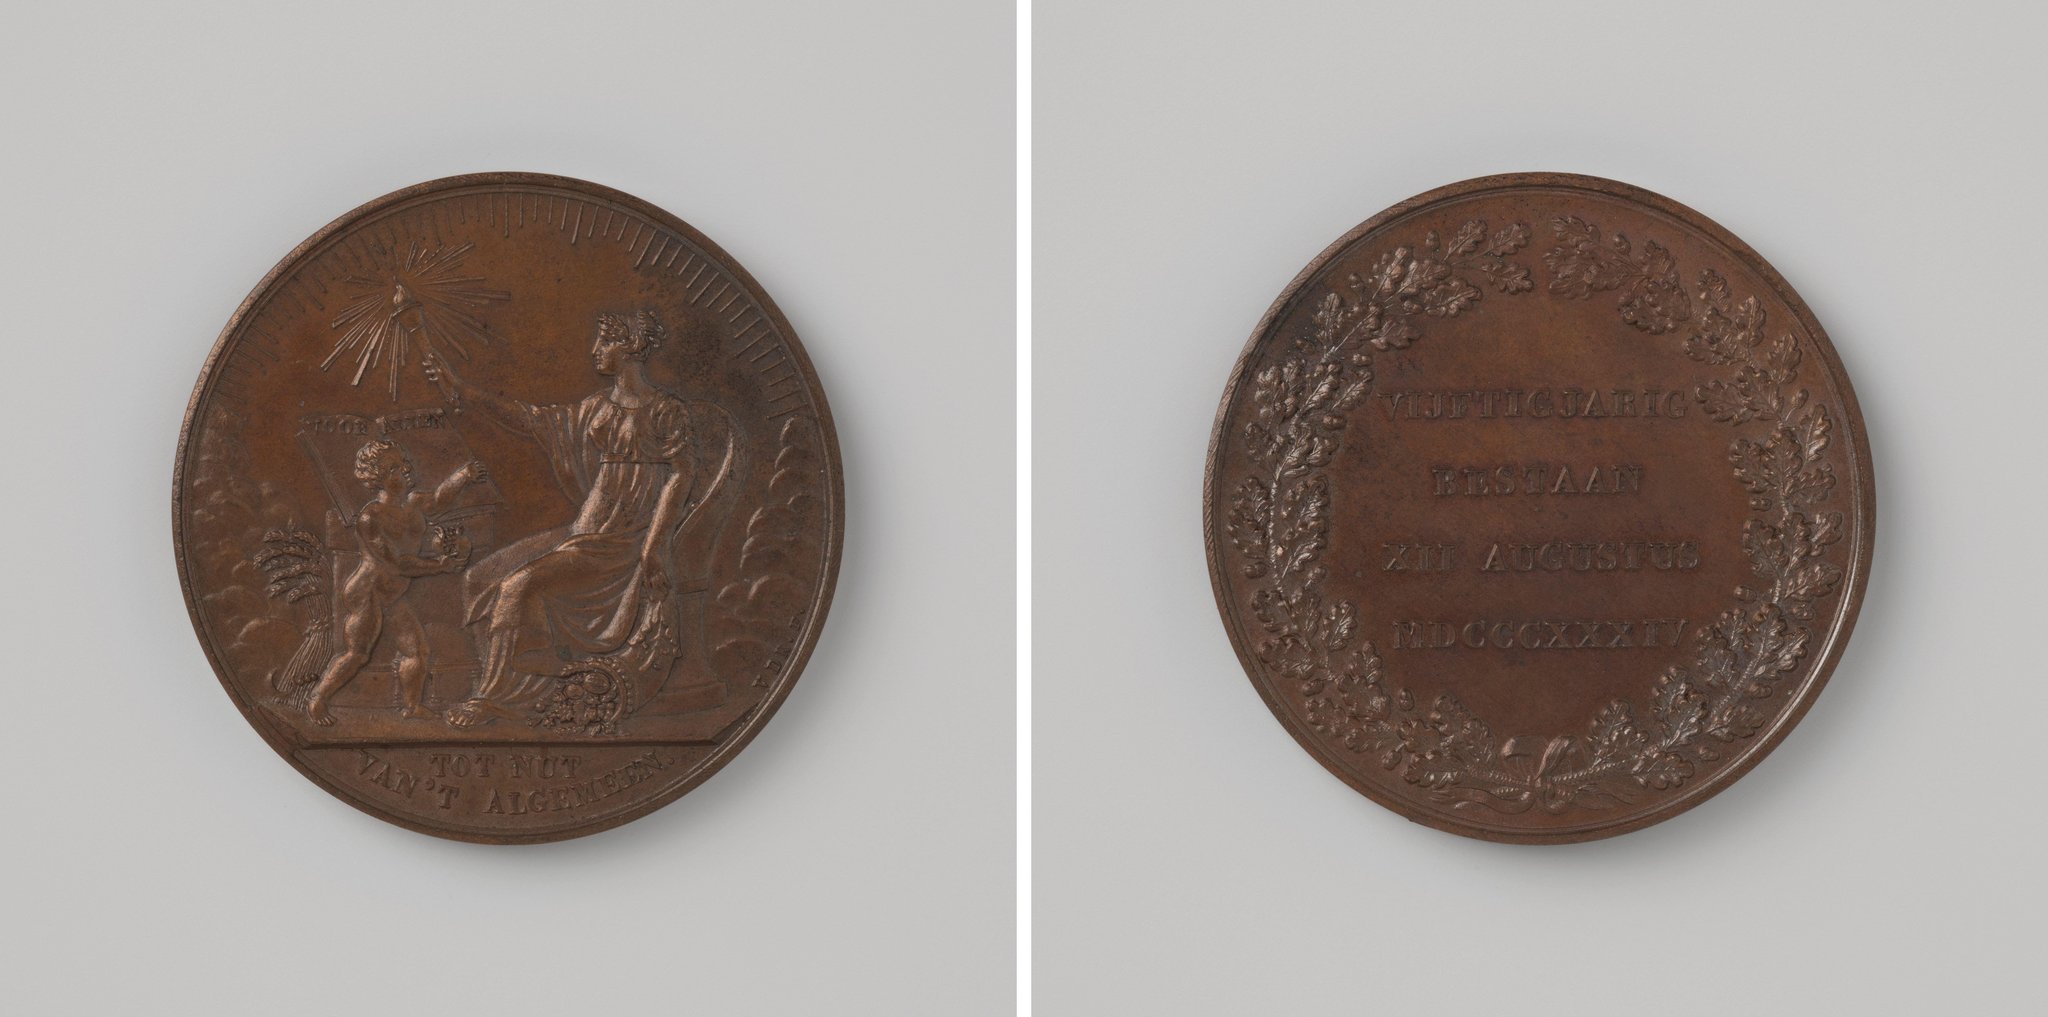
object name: history medal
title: Vijftigjarig bestaan van de Maatschappij tot Nut van 't Algemeen 1834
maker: david van der kellen (1804-1879)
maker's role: die cutter, draughtsman, print maker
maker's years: 1804-1879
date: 1834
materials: bronze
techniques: striking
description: Bronzen penning, op de voorzijde de Maatschappij als getroonde vrouw met hoorn des overvloeds en fakkel bij een altaar, waarop een open boek beschreven VOOR ALLEN, waarnaast een knaapje met een open granaatappel, alles te midden van wolken en vanaf de penningrand beschenen door vijftig stralen, met afsnedetekst, op de keerzijde vier regels tekst tussen samengestrikte eikentakken.